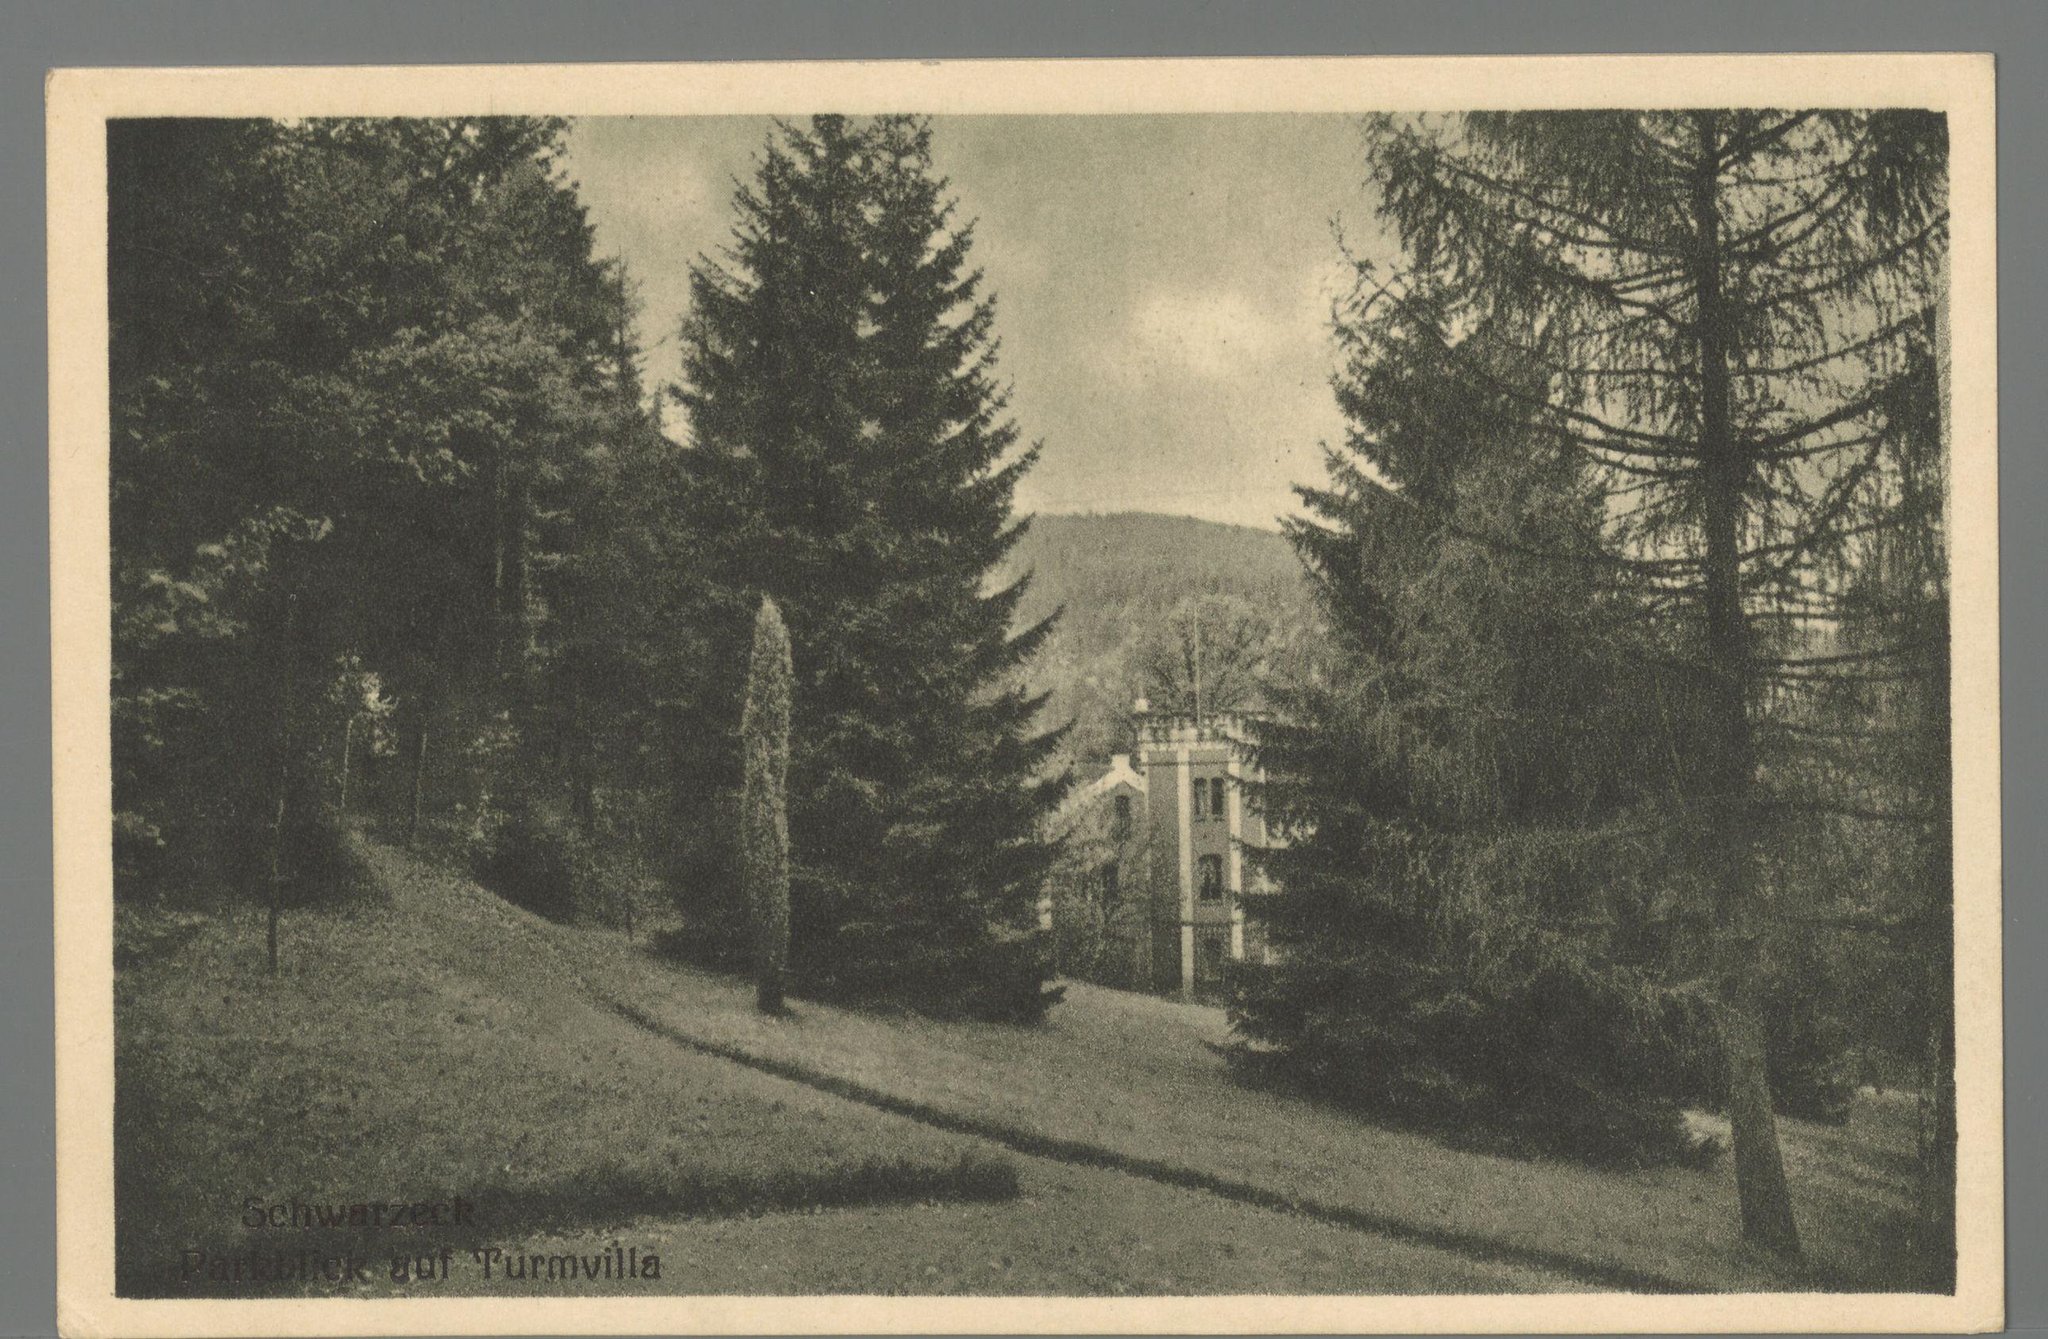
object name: ansichtkaart, prentbriefkaart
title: Schwarzeck. Parkblick auf Turmvilla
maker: Anonymous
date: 1905-1930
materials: cardboard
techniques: rotogravure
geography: schwarzeck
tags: villa, mountains